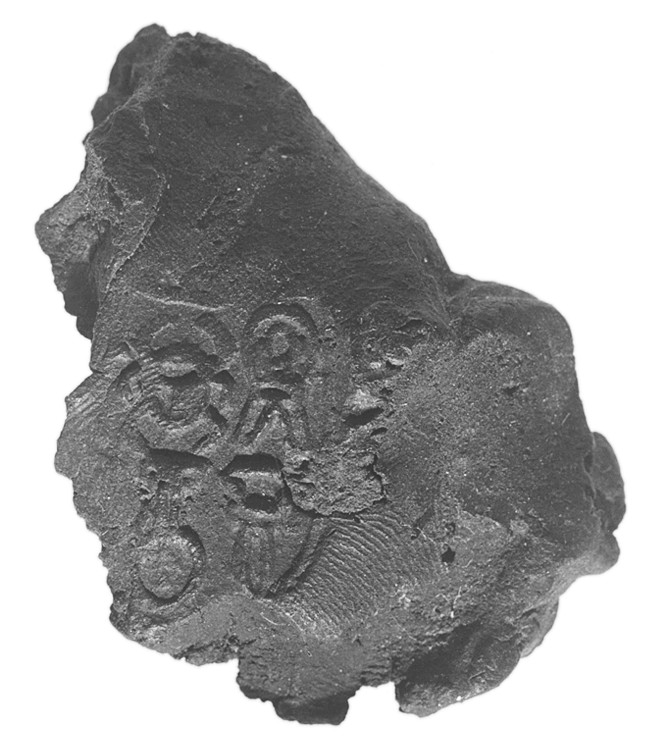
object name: sealing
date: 2030-1640 BCE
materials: clay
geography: egypt